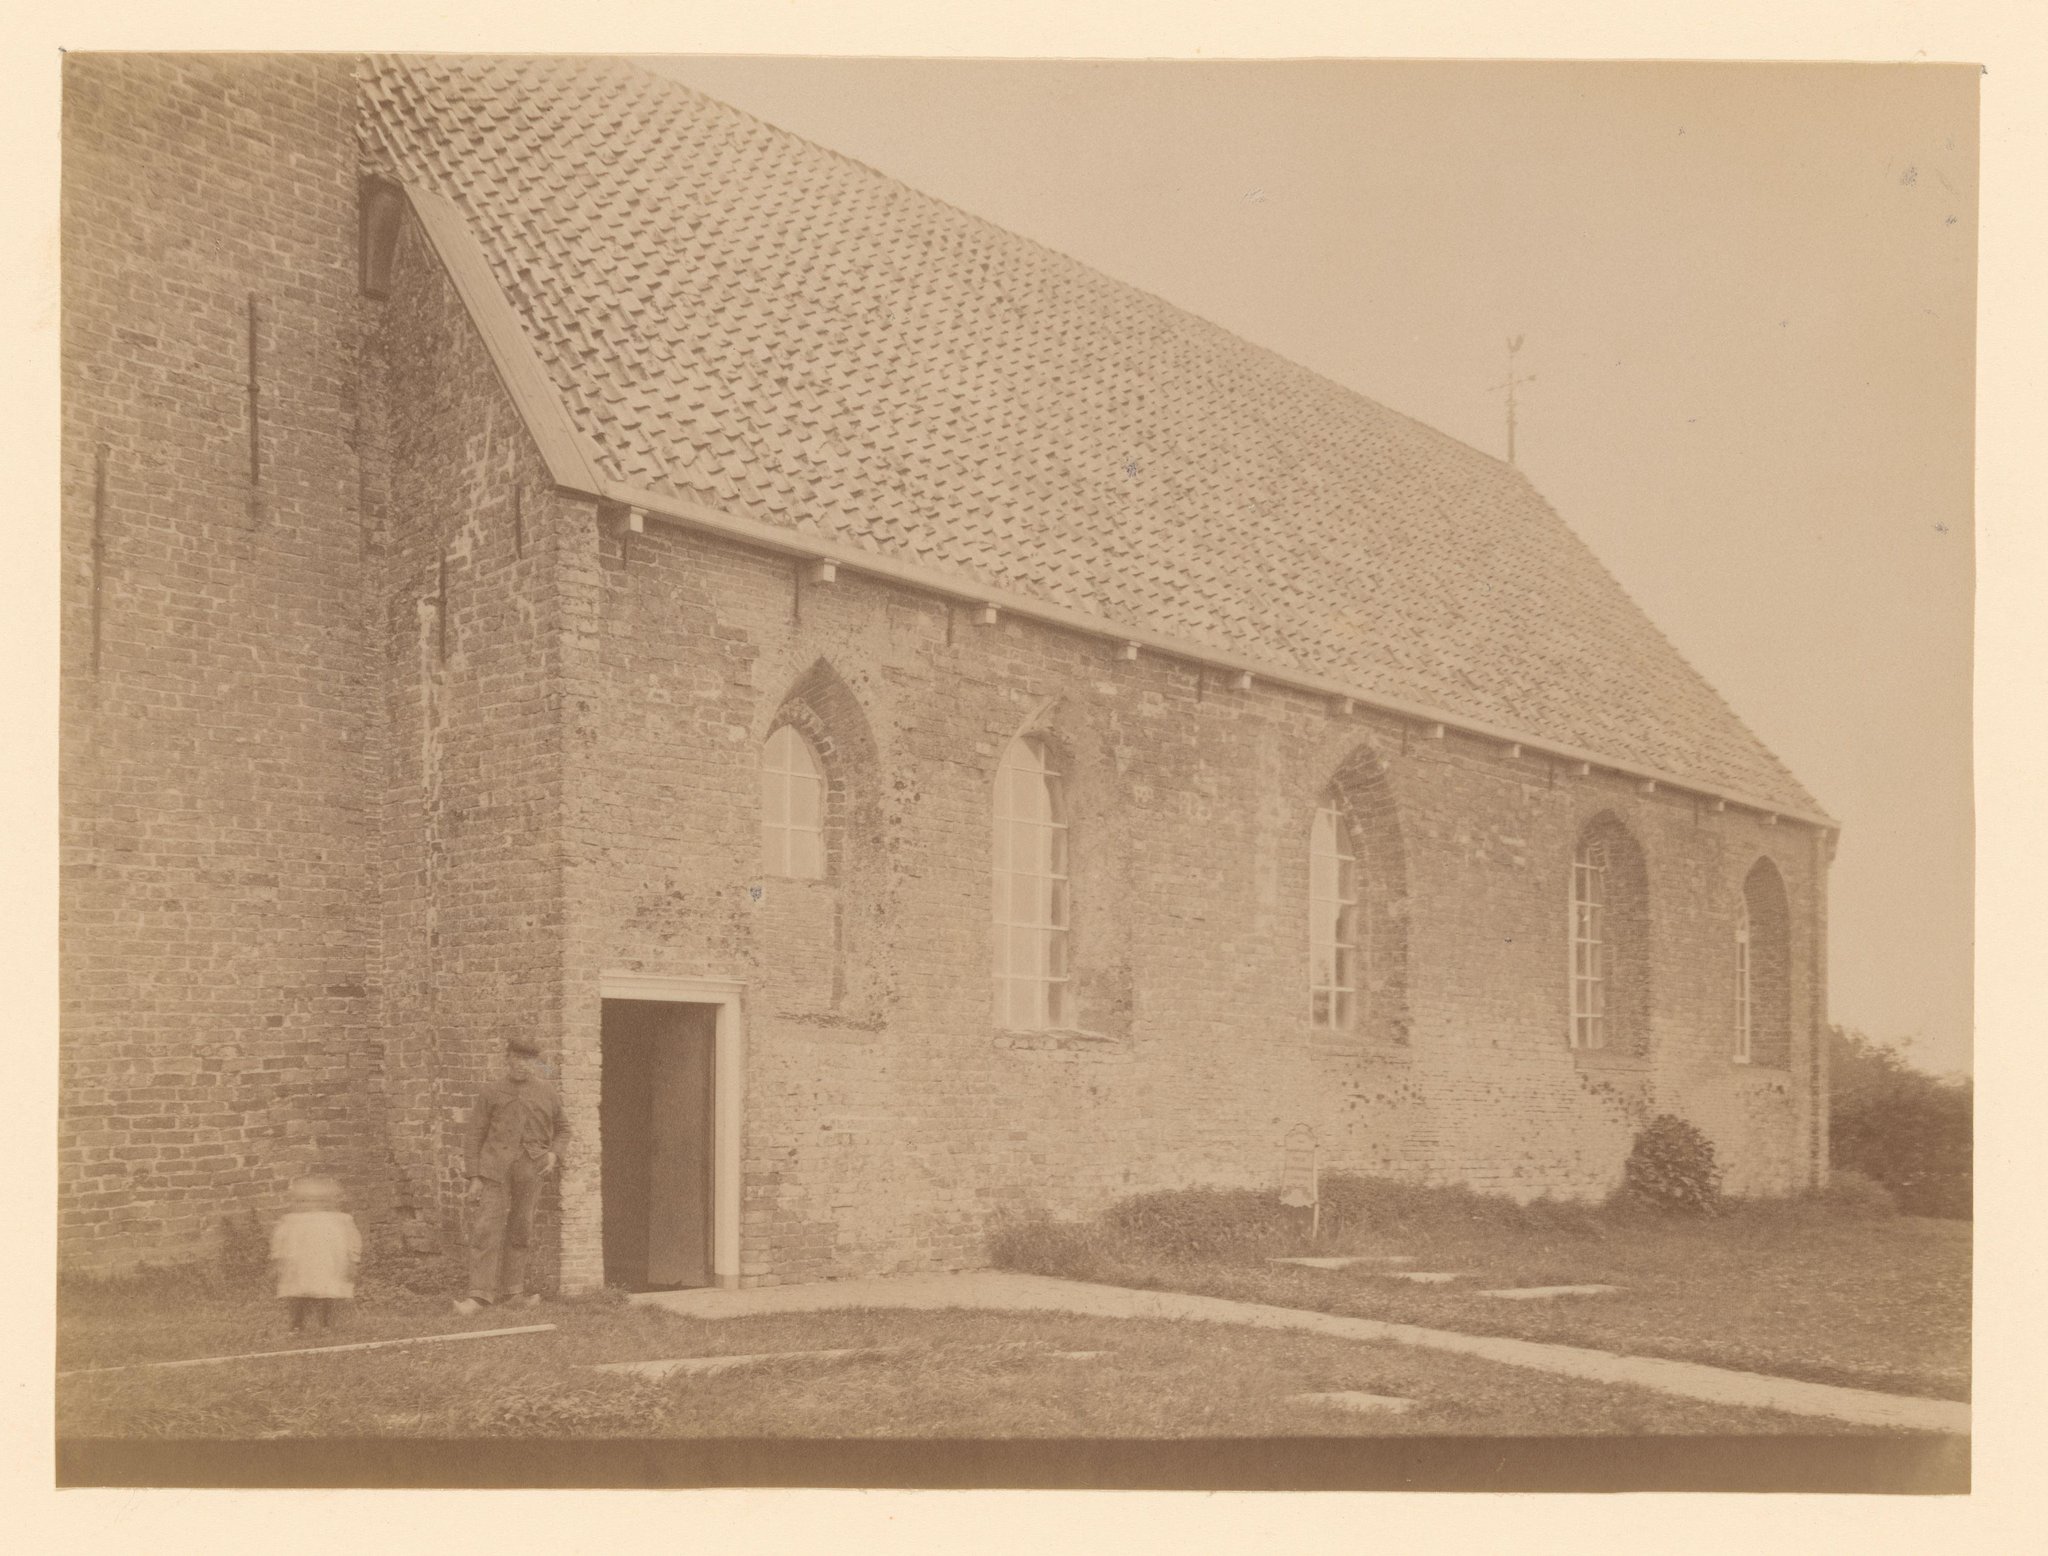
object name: photograph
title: Zuidzijde van de voormalige Hervormde Kerk te Oosterwierum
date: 1902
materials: cardboard, photographic support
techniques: albumen print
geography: oosterwierum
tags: church (exterior)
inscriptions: annotation: ‘Oosterwierum/ Oosterwierum/ gem. Baarderadeel’, annotation: ‘Oosterwierum (Fr) / Zuiderzijde der / N.H. Kerk / Aug 1902 / Baarderadeel’